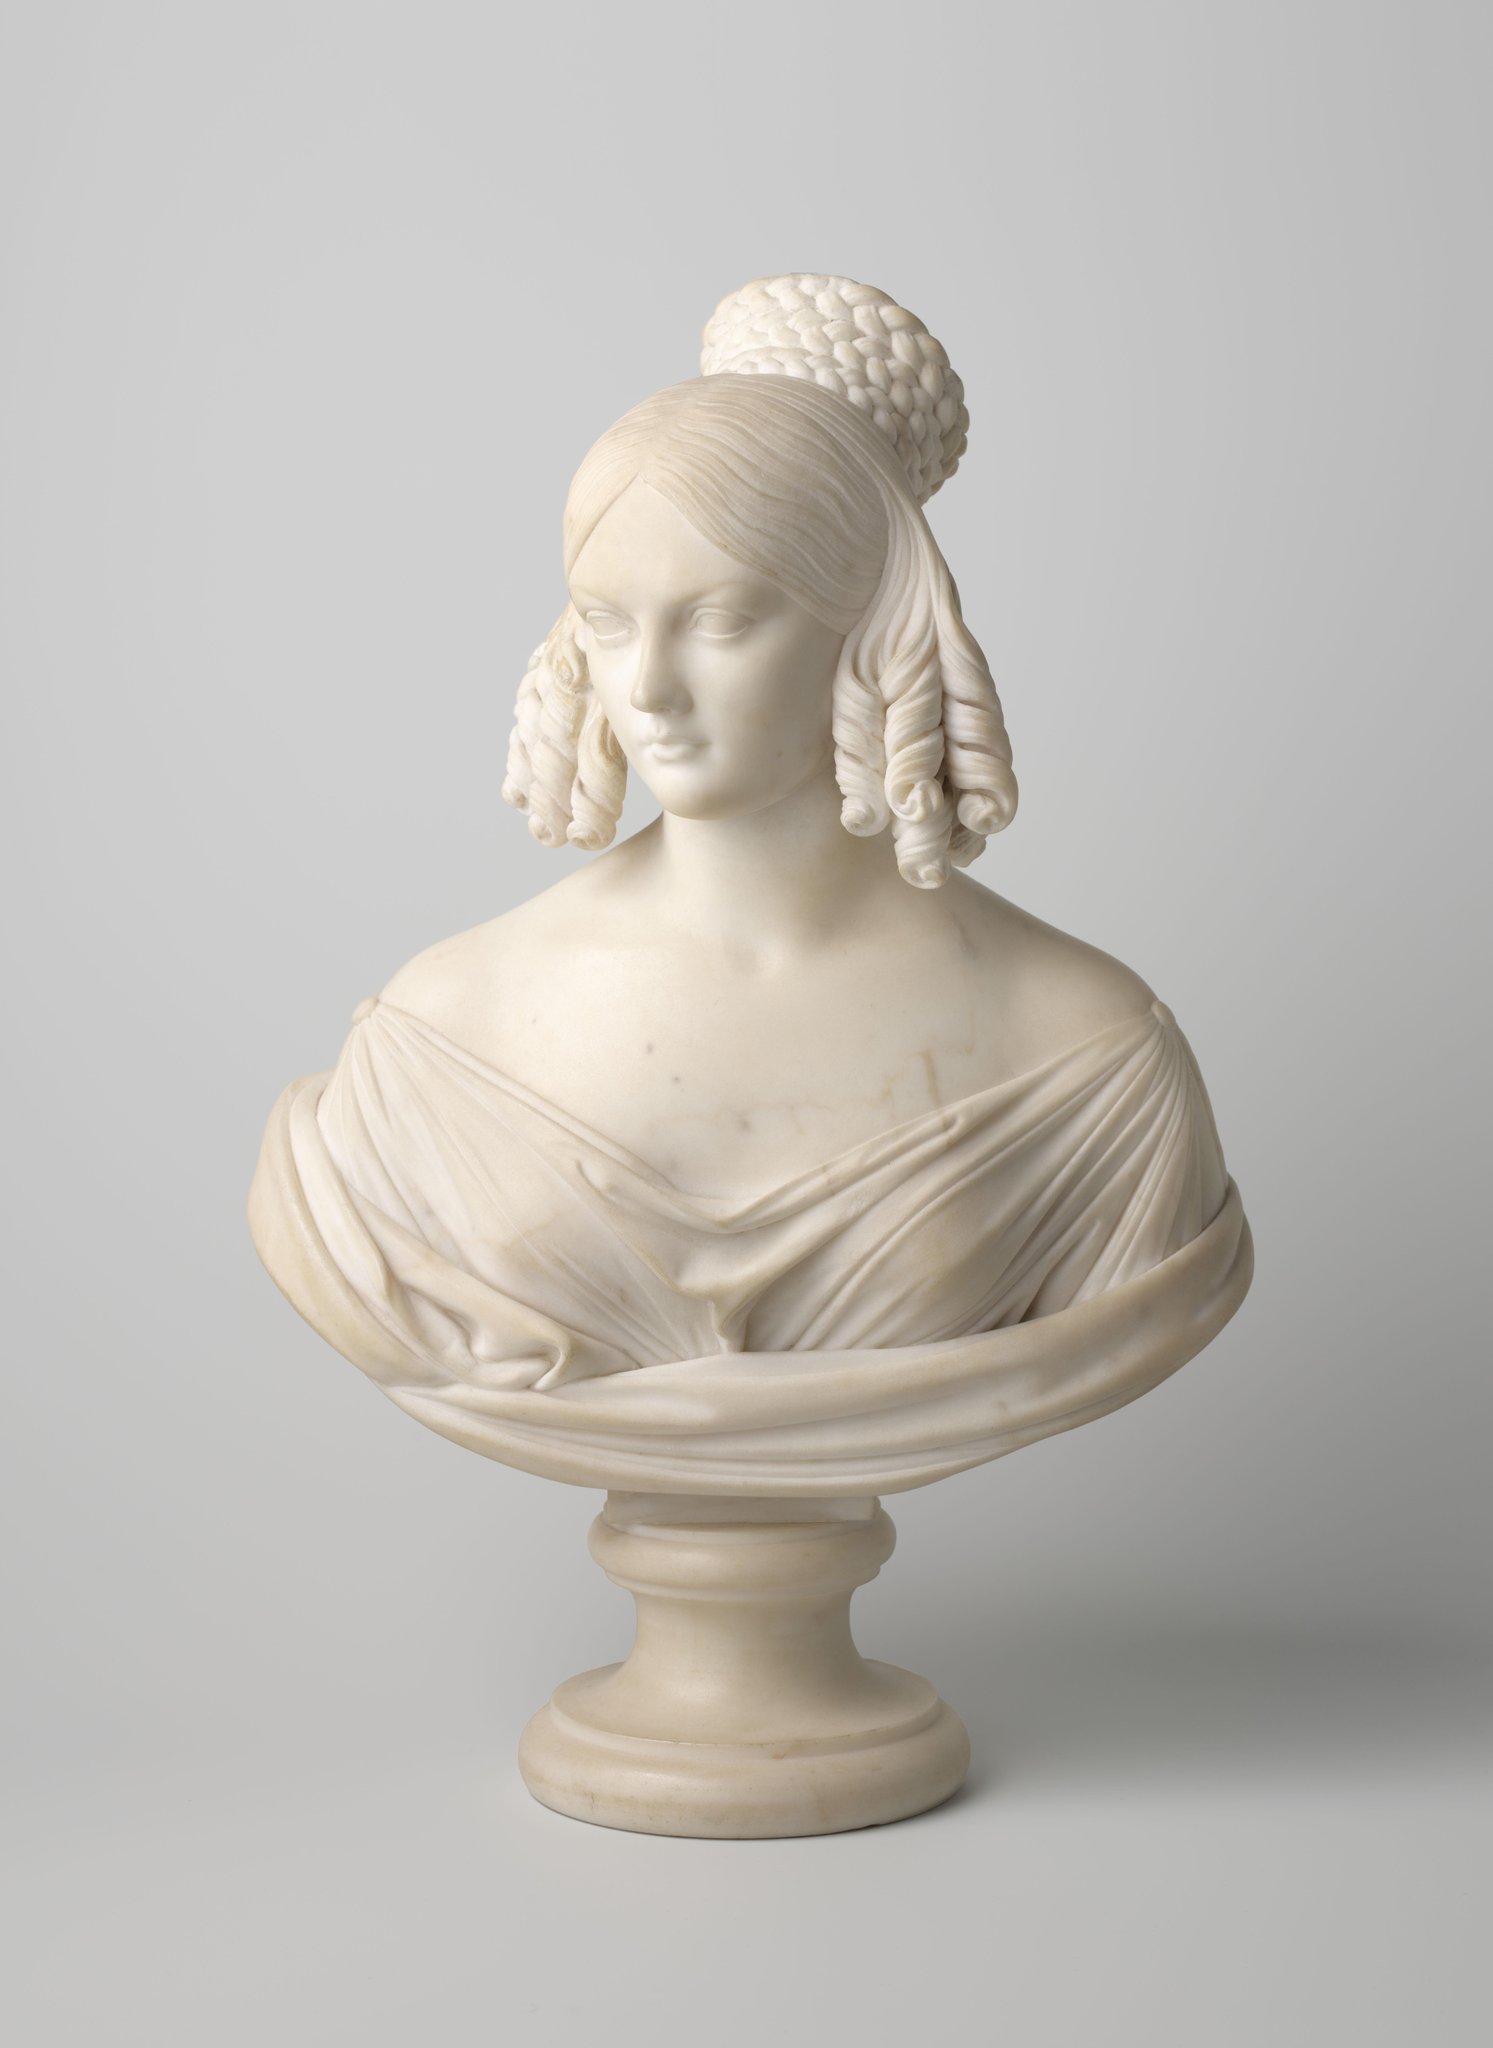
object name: sculpture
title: Portret van een onbekende dame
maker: lorenzo bartolini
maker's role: draughtsman, sculptor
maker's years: 1777-1850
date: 1833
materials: marble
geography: florence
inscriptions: signature and date (false): ‘PRADIER 1844’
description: Jean-Jacques Pradier (1790 - 1852). Young woman. Marble. Paris, 1844.